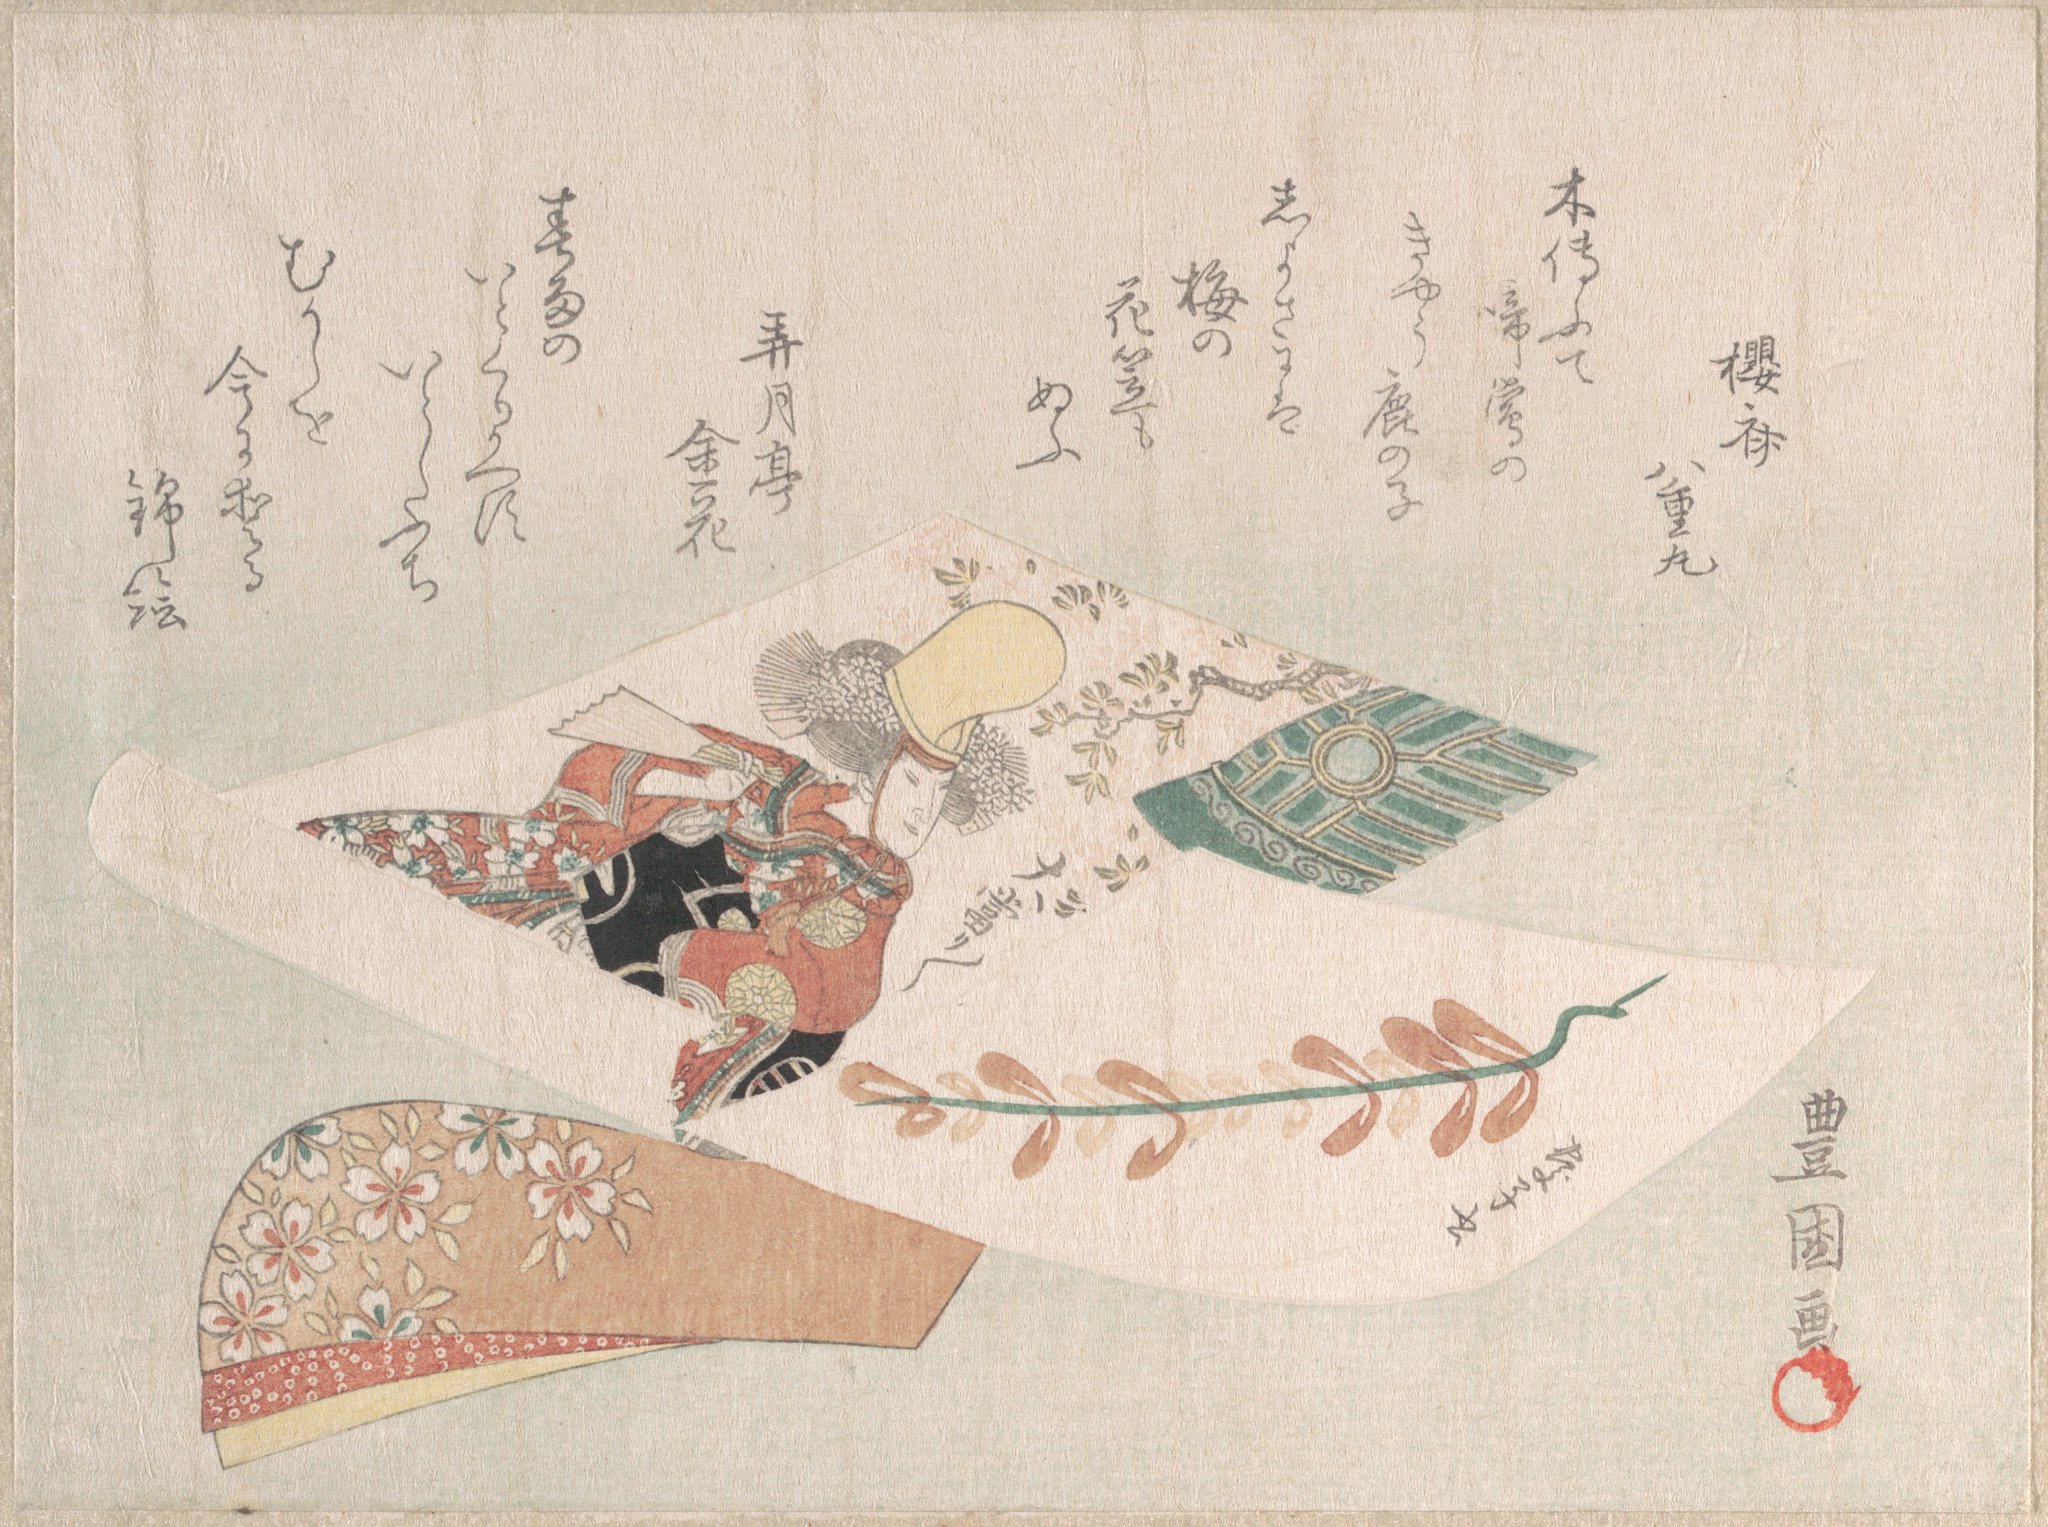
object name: print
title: Representation of the Dance-Play "Dōjōji"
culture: japanese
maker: utagawa toyokuni i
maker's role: artist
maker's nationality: japanese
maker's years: 1769-1825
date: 1769-1825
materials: ink, paper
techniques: surimono, woodblock print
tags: women,flowers